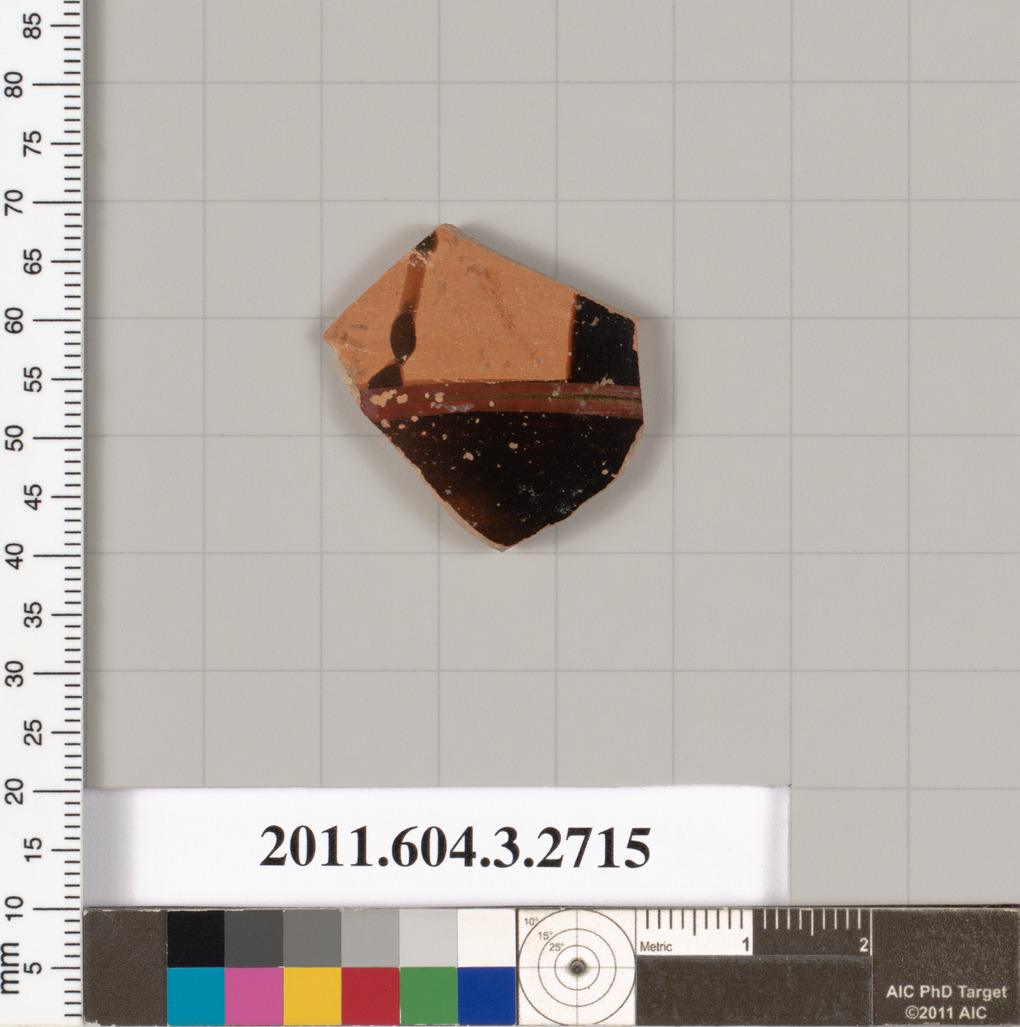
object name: olpe fragment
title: Terracotta fragment of an olpe (jug)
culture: greek, attic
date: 534-468 BCE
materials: terracotta